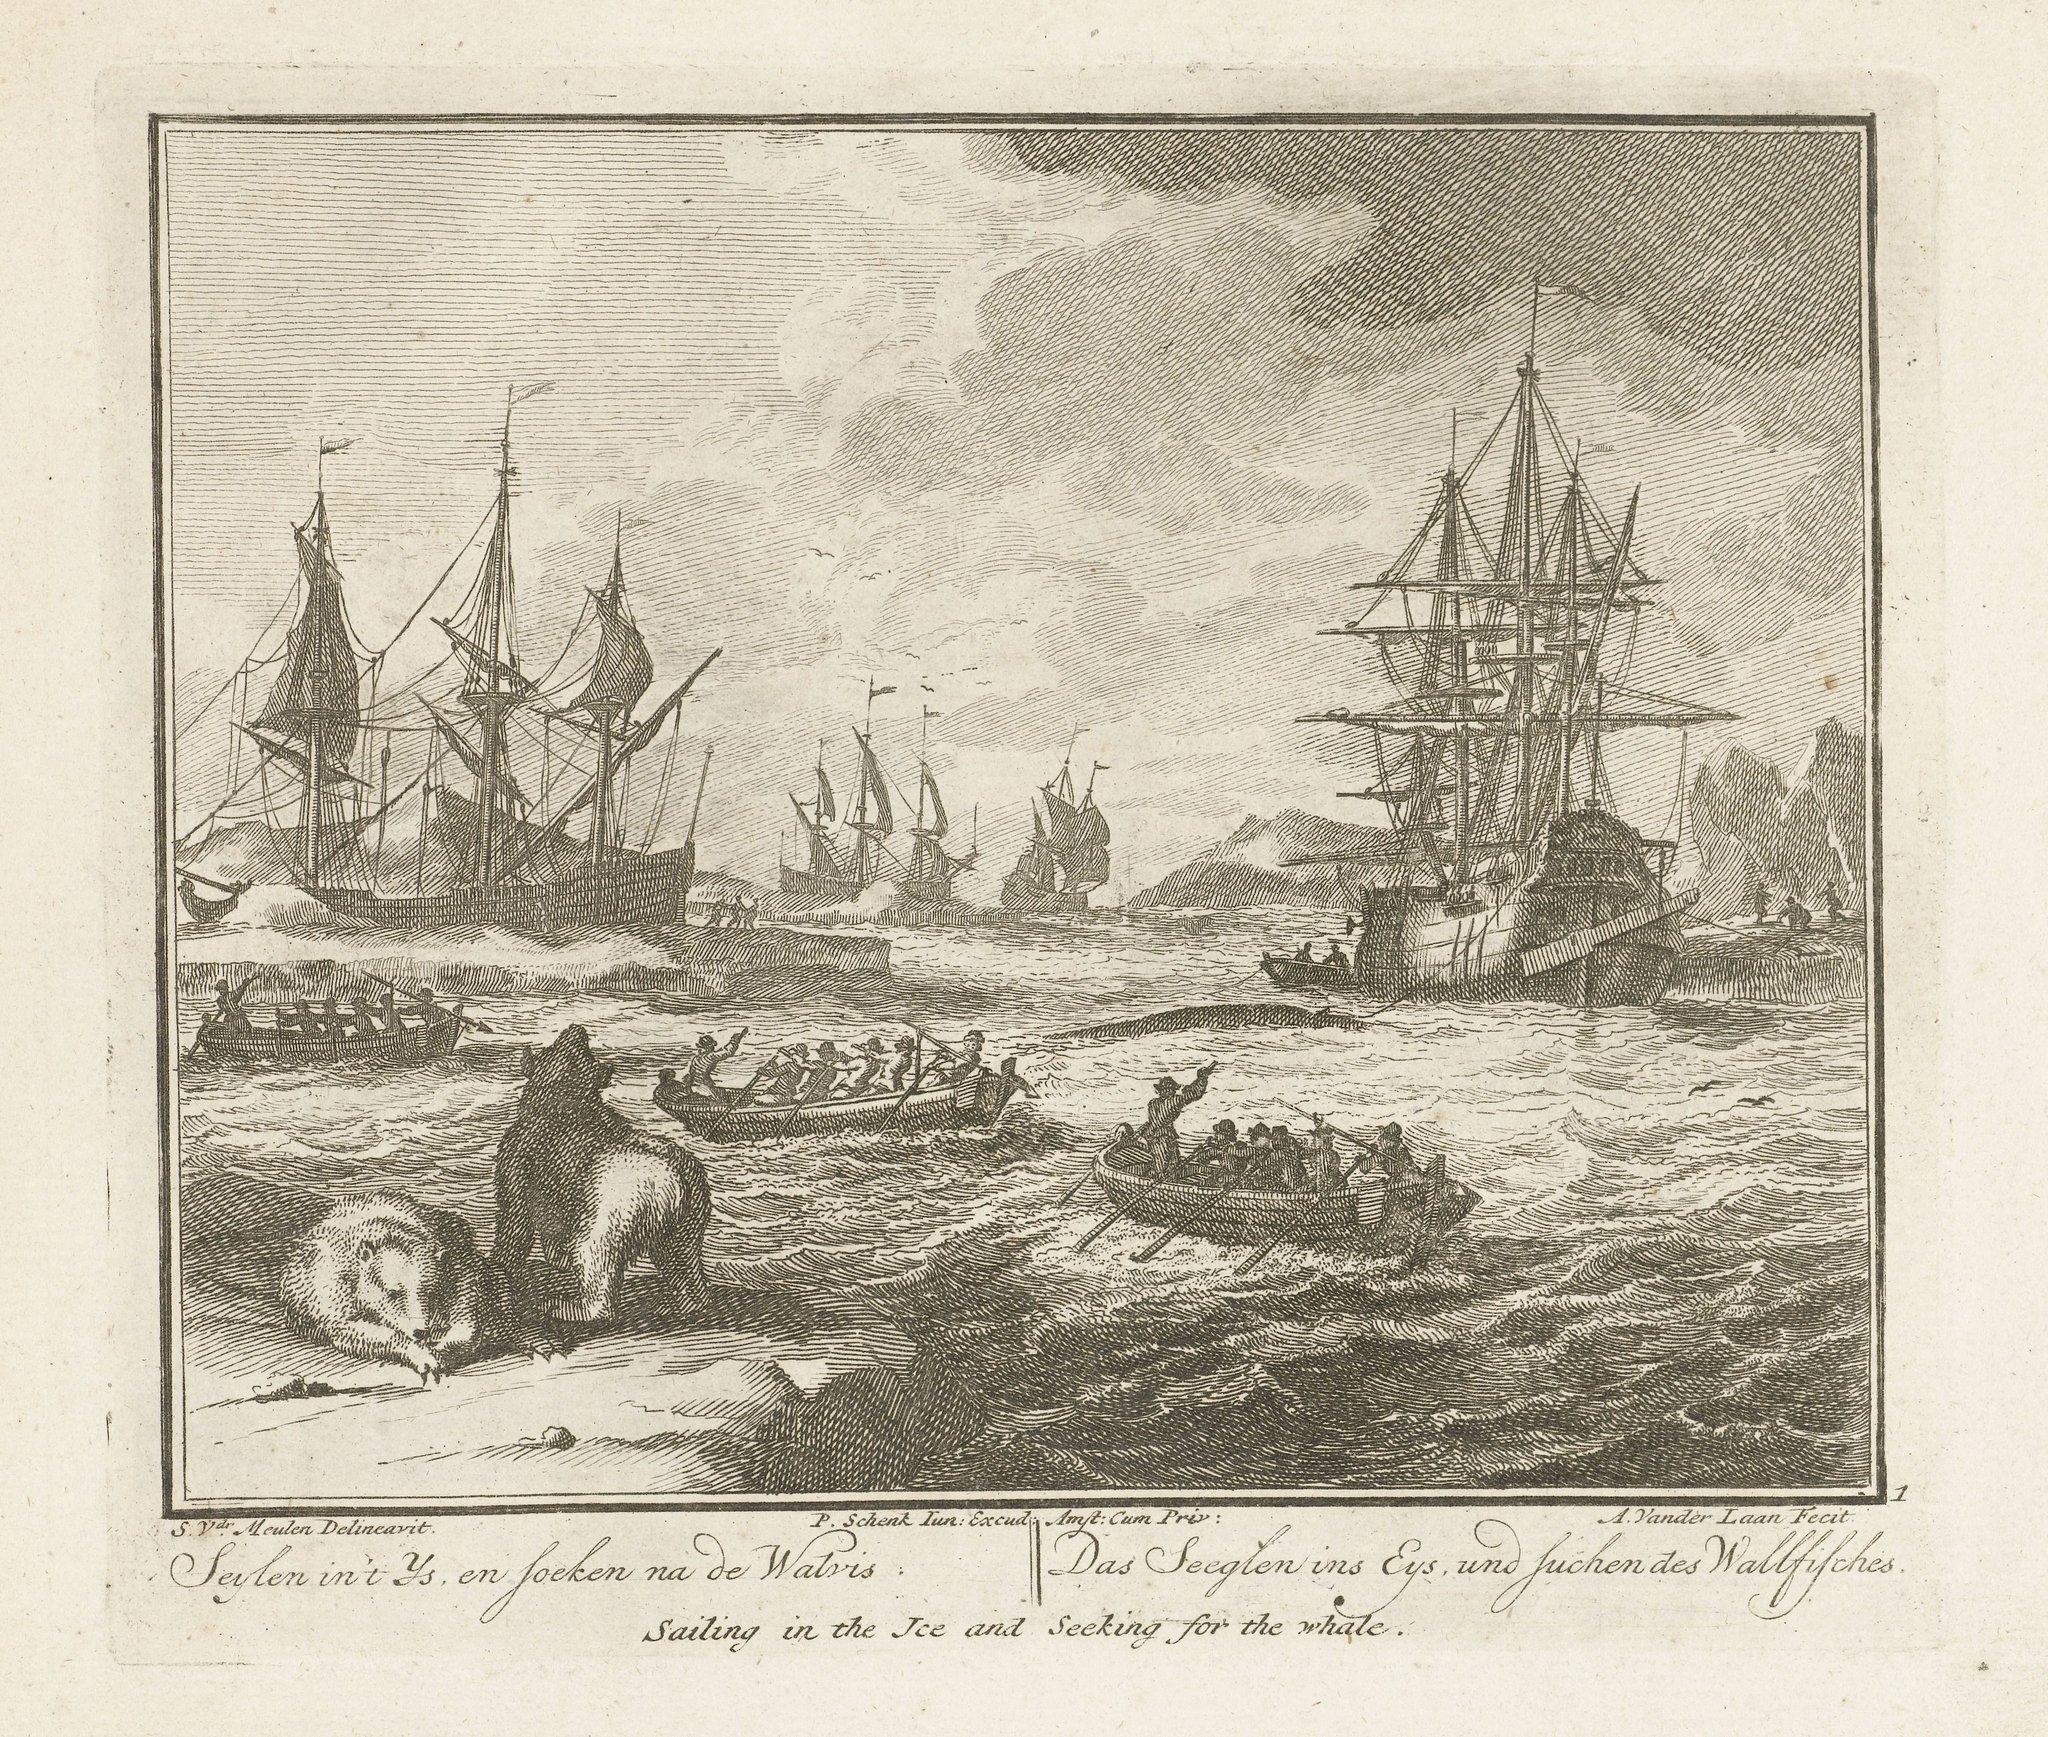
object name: print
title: Seylen in 't Ys, en soeken na de Walvis / Das Seeglen ins Eys, und suchen des Wallfisches / Sailing in the Ice and Seeking for the whale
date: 1720-1730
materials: paper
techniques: etching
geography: amsterdam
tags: beasts of prey, predatory animals: polar bear, whale fishery, whaling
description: Walvisjacht in de ijszee, ca. 1725. Op de voorgrond enkele ijsberen. Onderdeel van de serie over de walvisvangst. Gedrukt op hetzelfde blad als nr. 2.